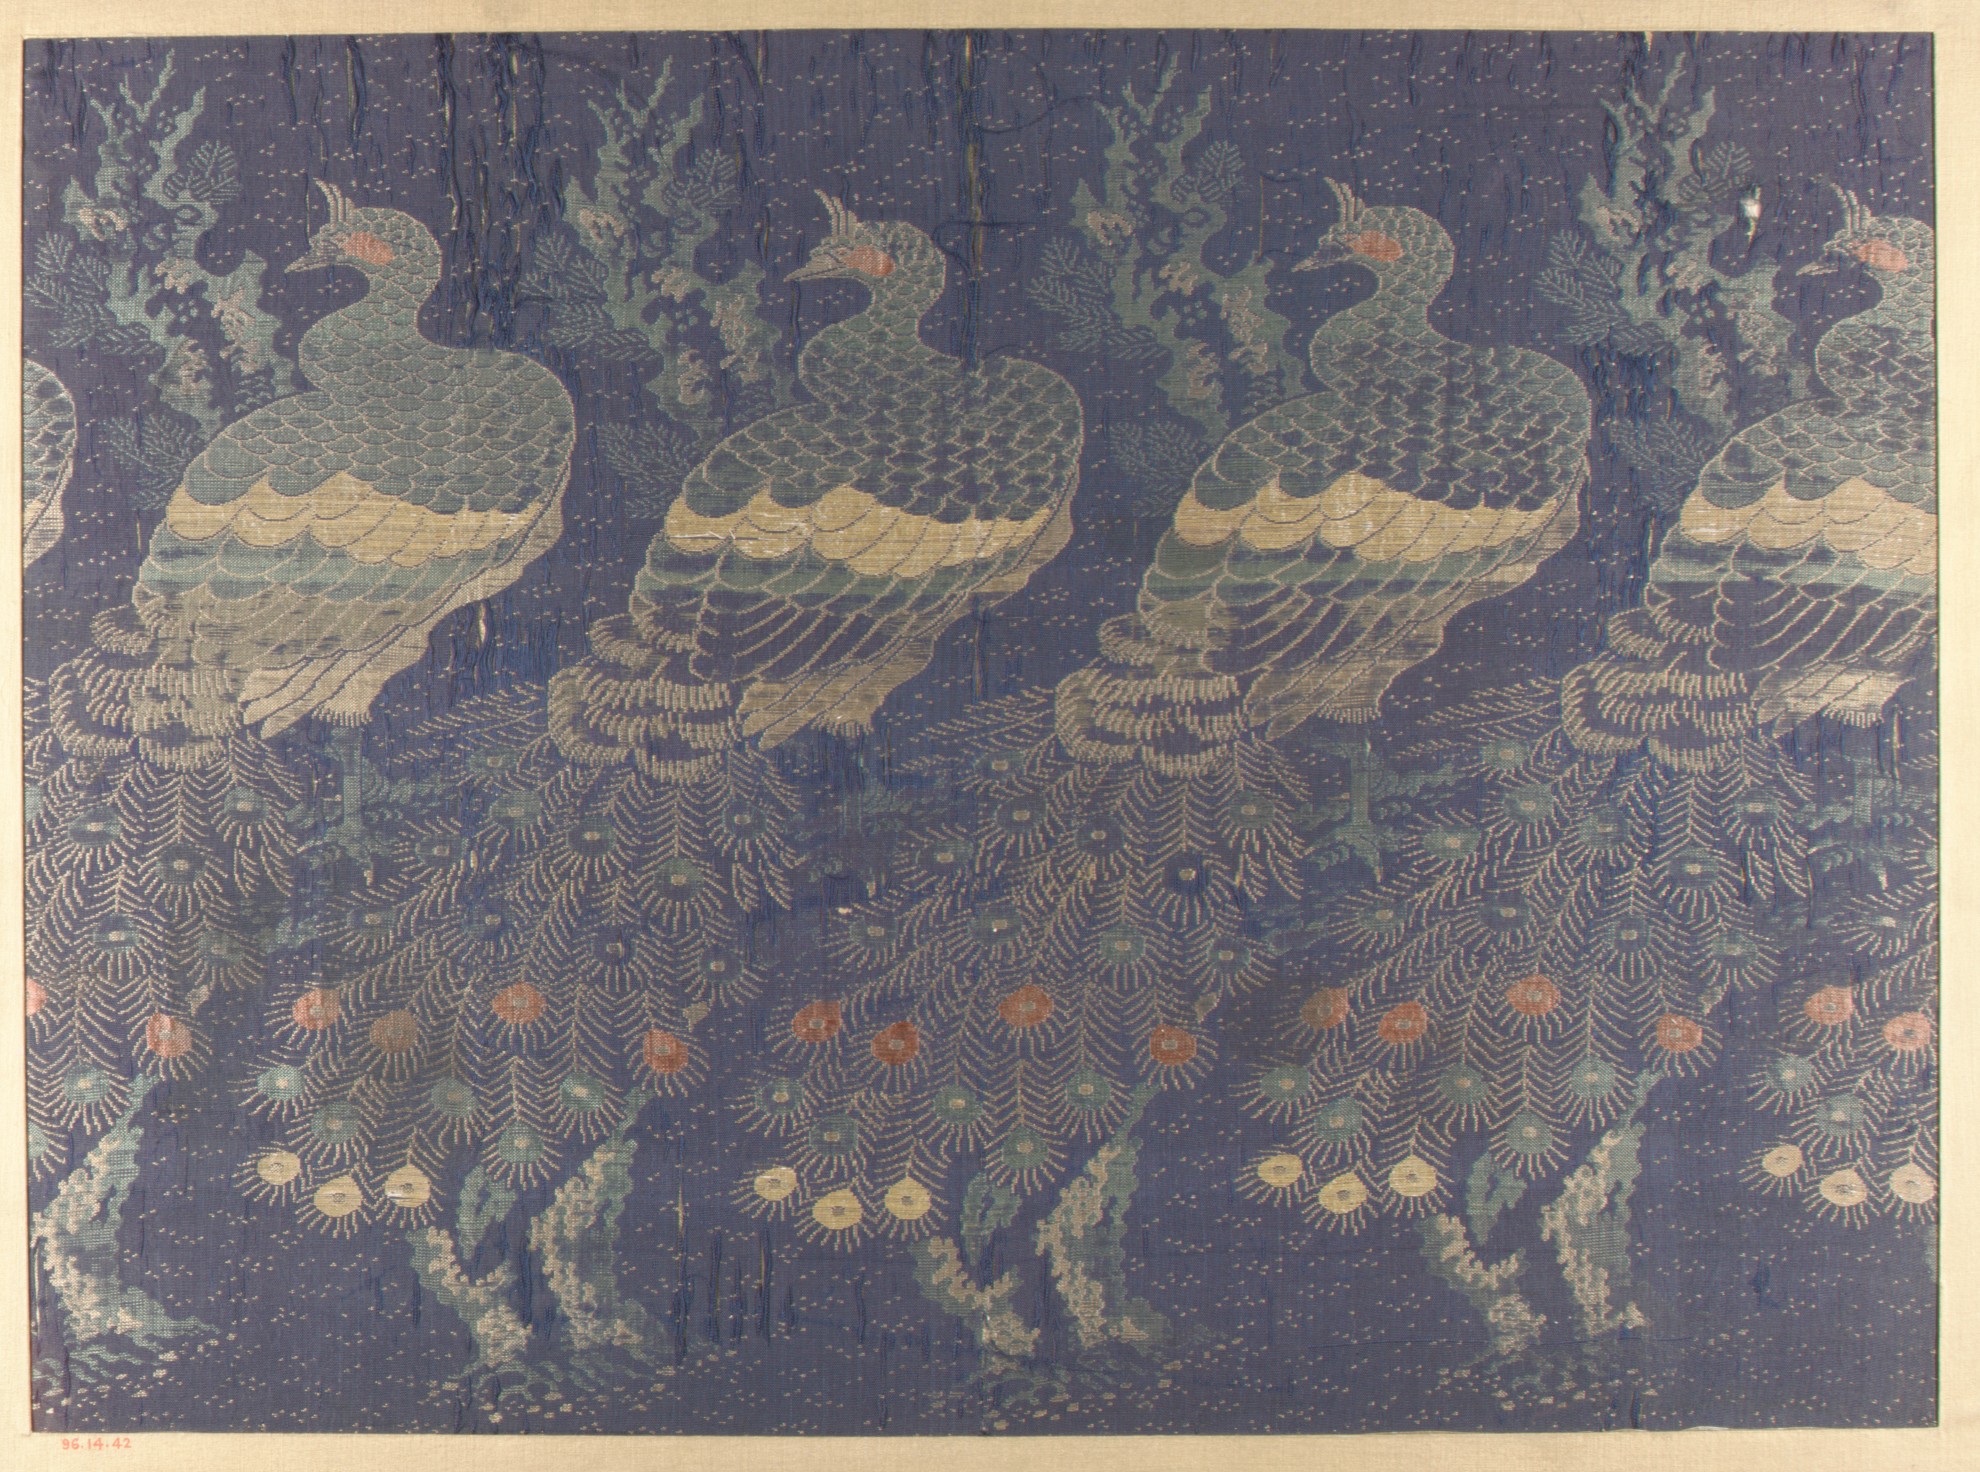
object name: piece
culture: japanese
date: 1801-1900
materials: silk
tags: peacocks